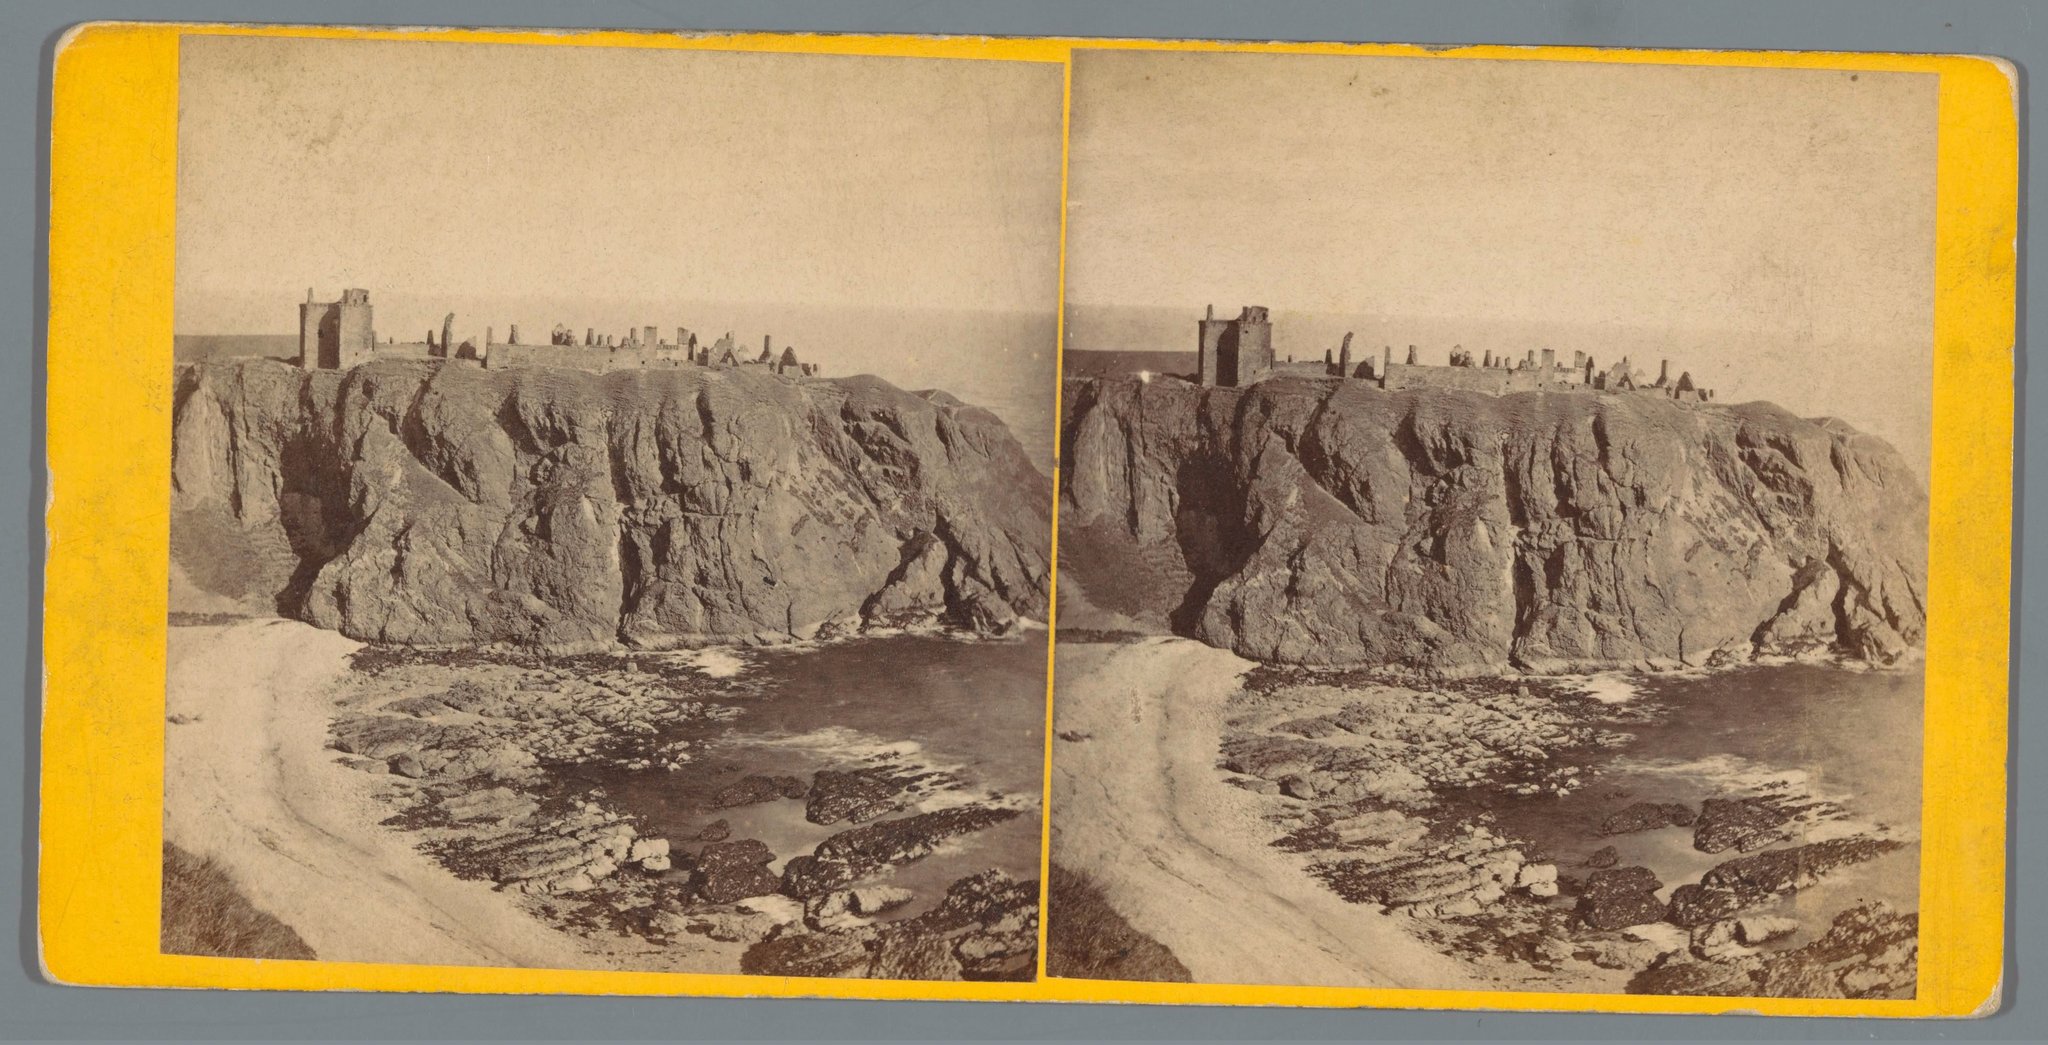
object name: stereograph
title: Dunnotar Castle, Kincardineshire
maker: george washington wilson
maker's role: publisher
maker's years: 1823-1893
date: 1860-1865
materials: cardboard, photographic support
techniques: albumen print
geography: aberdeen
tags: schotland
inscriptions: label: ‘G.W. Wilson & Co, Aberdeen No. 596 Dunnotar Castle, Kincardineshire’